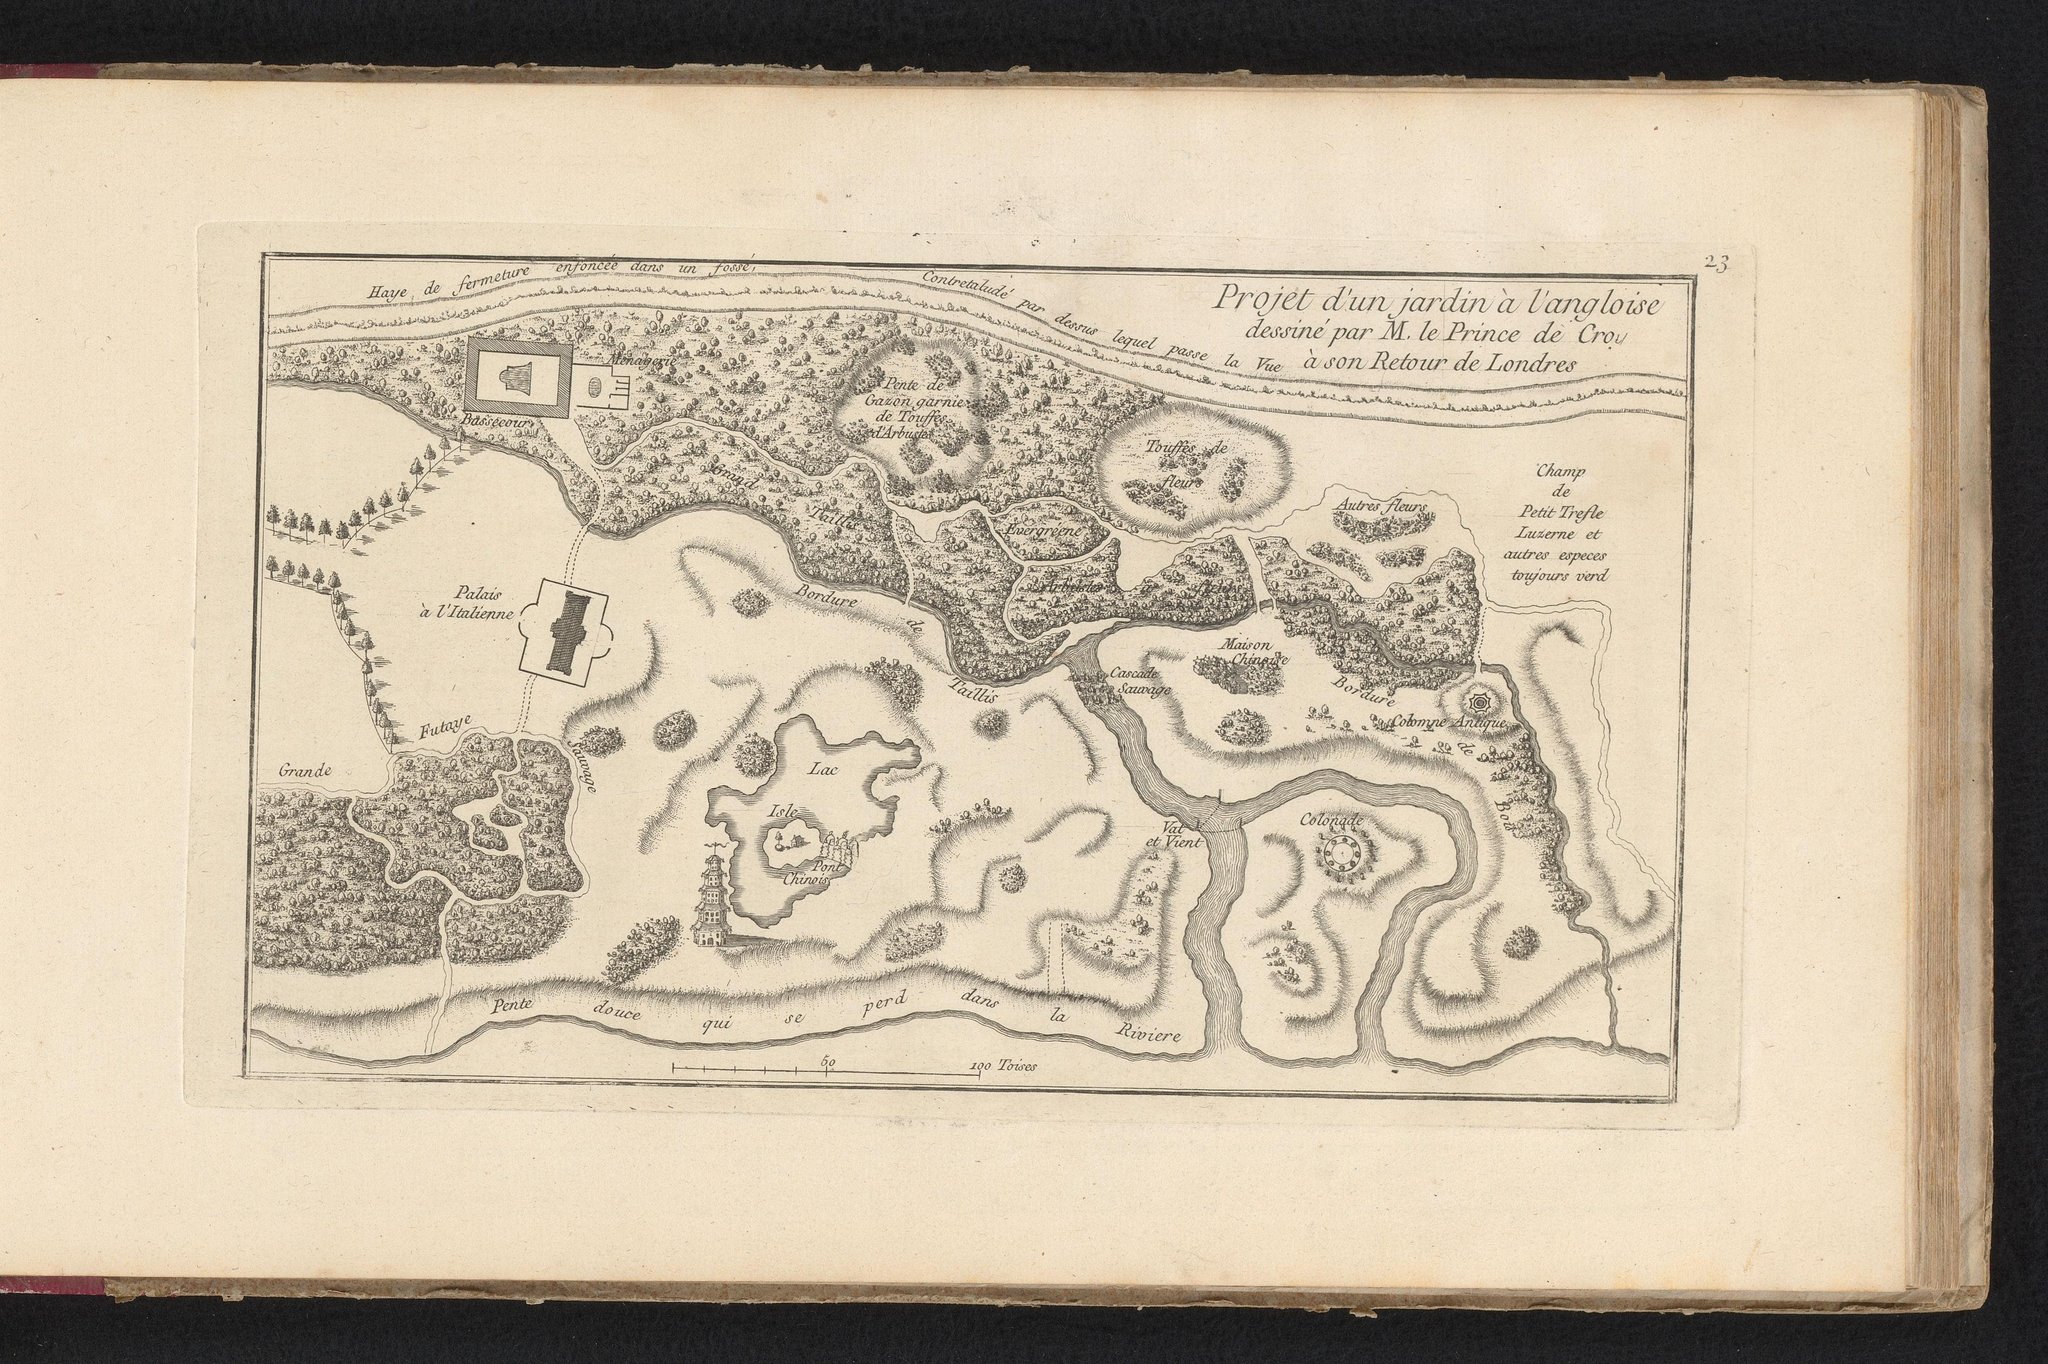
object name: album leaf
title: Ontwerp voor een Engelse tuin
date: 1775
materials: paper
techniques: engraving, etching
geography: paris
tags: plan, map of garden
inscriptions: collector's mark: Lugt 2760, collector's mark: Lugt 2228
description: De serie 'Jardins anglo-chinois à la mode' verscheen in totaal in 21 zogeheten 'cahiers' (afleveringen). De huidige prent komt uit het eerste 'cahier'. Het Rijksmuseum Amsterdam bezit drie banden met daarin in totaal zes 'cahiers' van deze reeks. In de documentatie wordt verwezen naar een in de bibliotheek van het Rijksmuseum Amsterdam aanwezige facsimile van het complete werk.